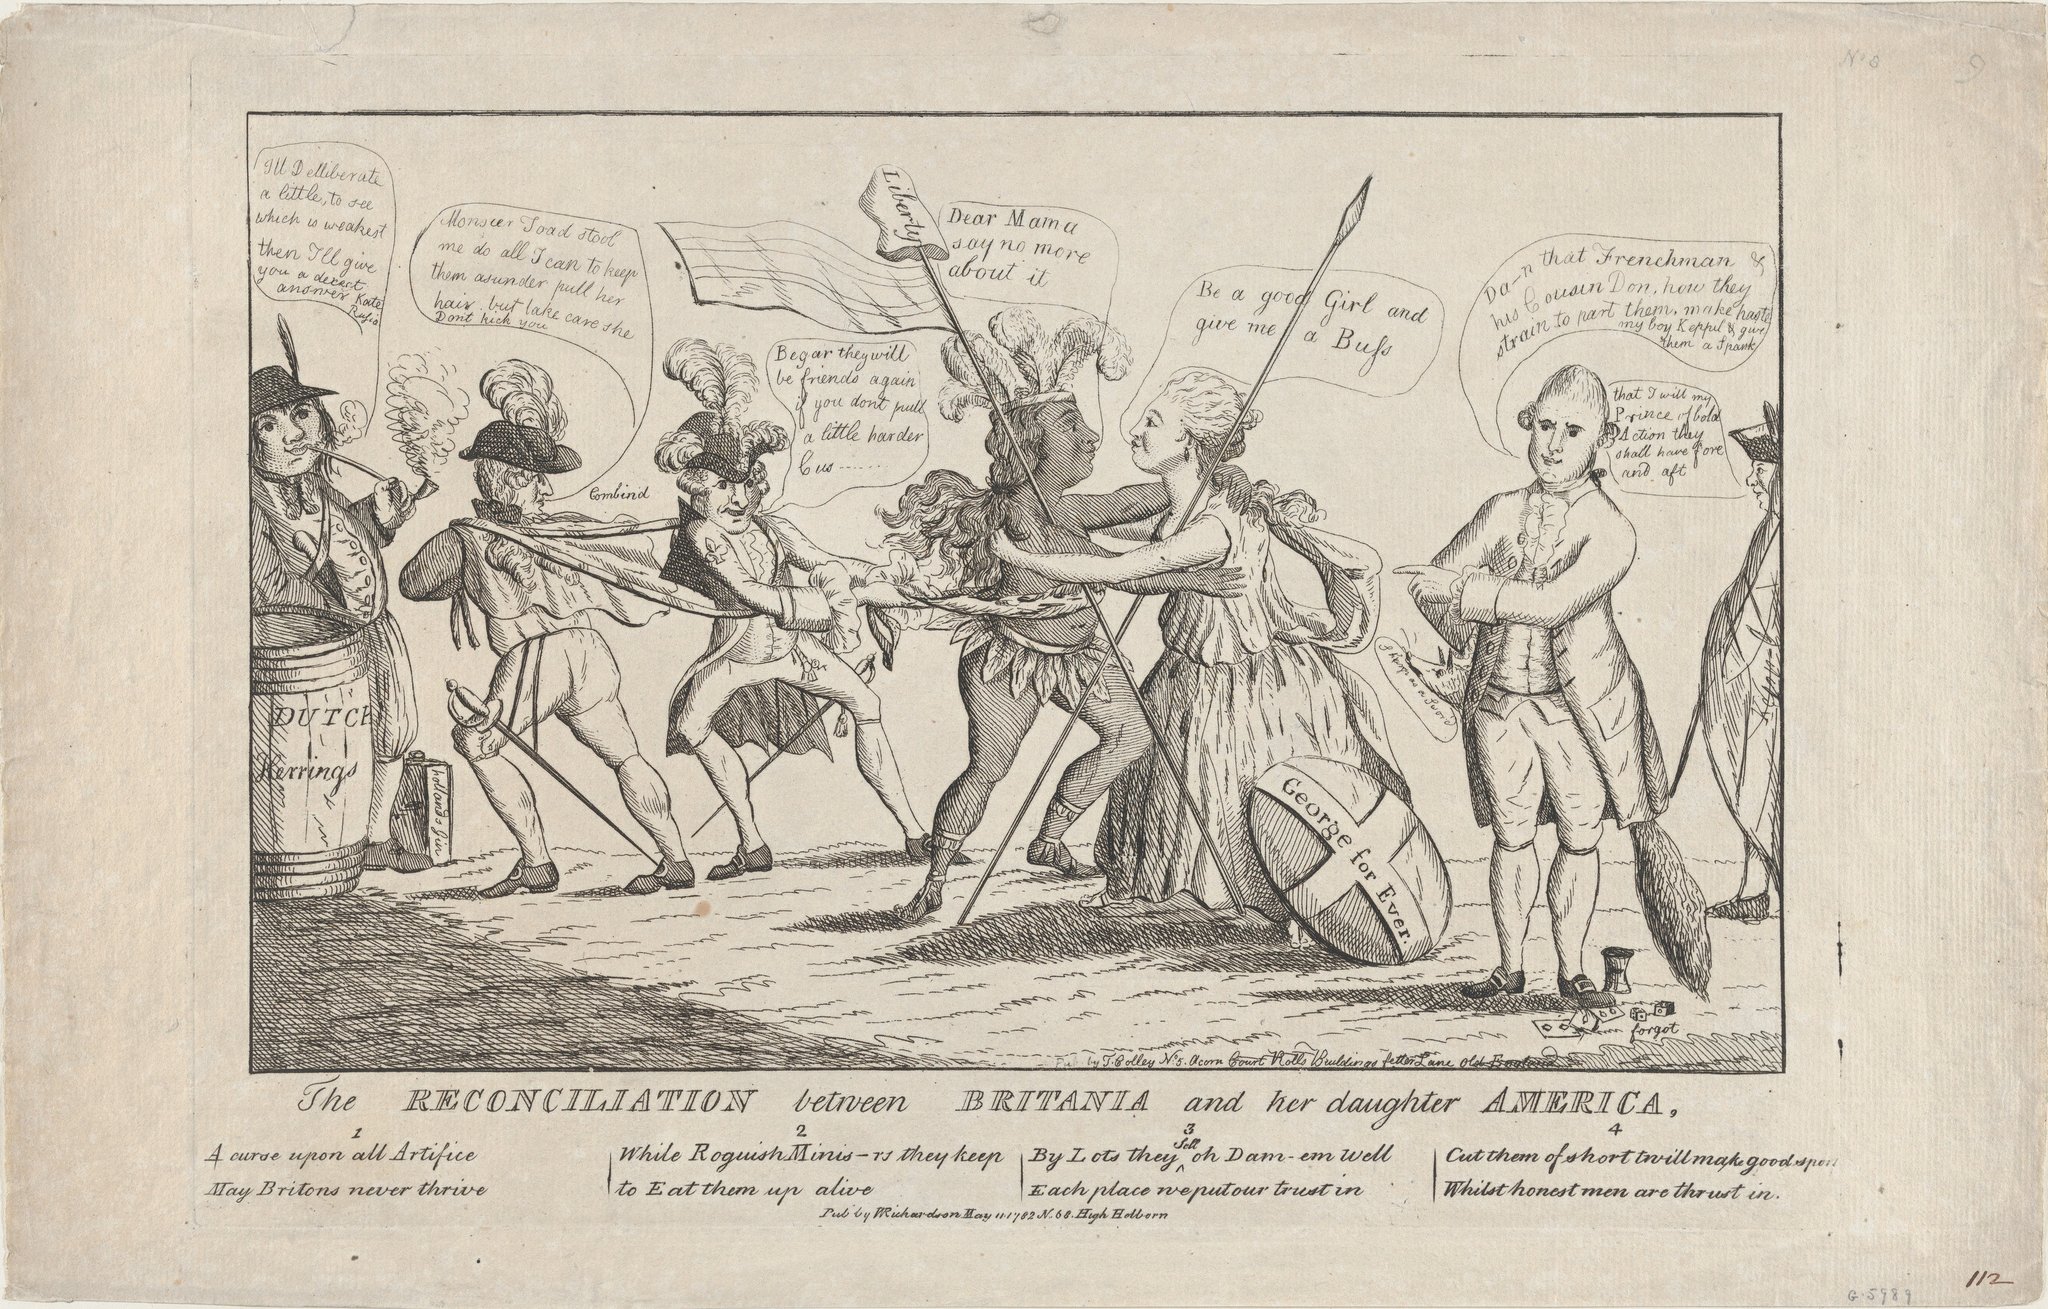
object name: print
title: The Reconciliation Between Britannia and Her Daughter America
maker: thomas colley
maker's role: artist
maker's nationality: british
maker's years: 1778-1783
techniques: etching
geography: london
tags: satire,american revolution,men,women,politics